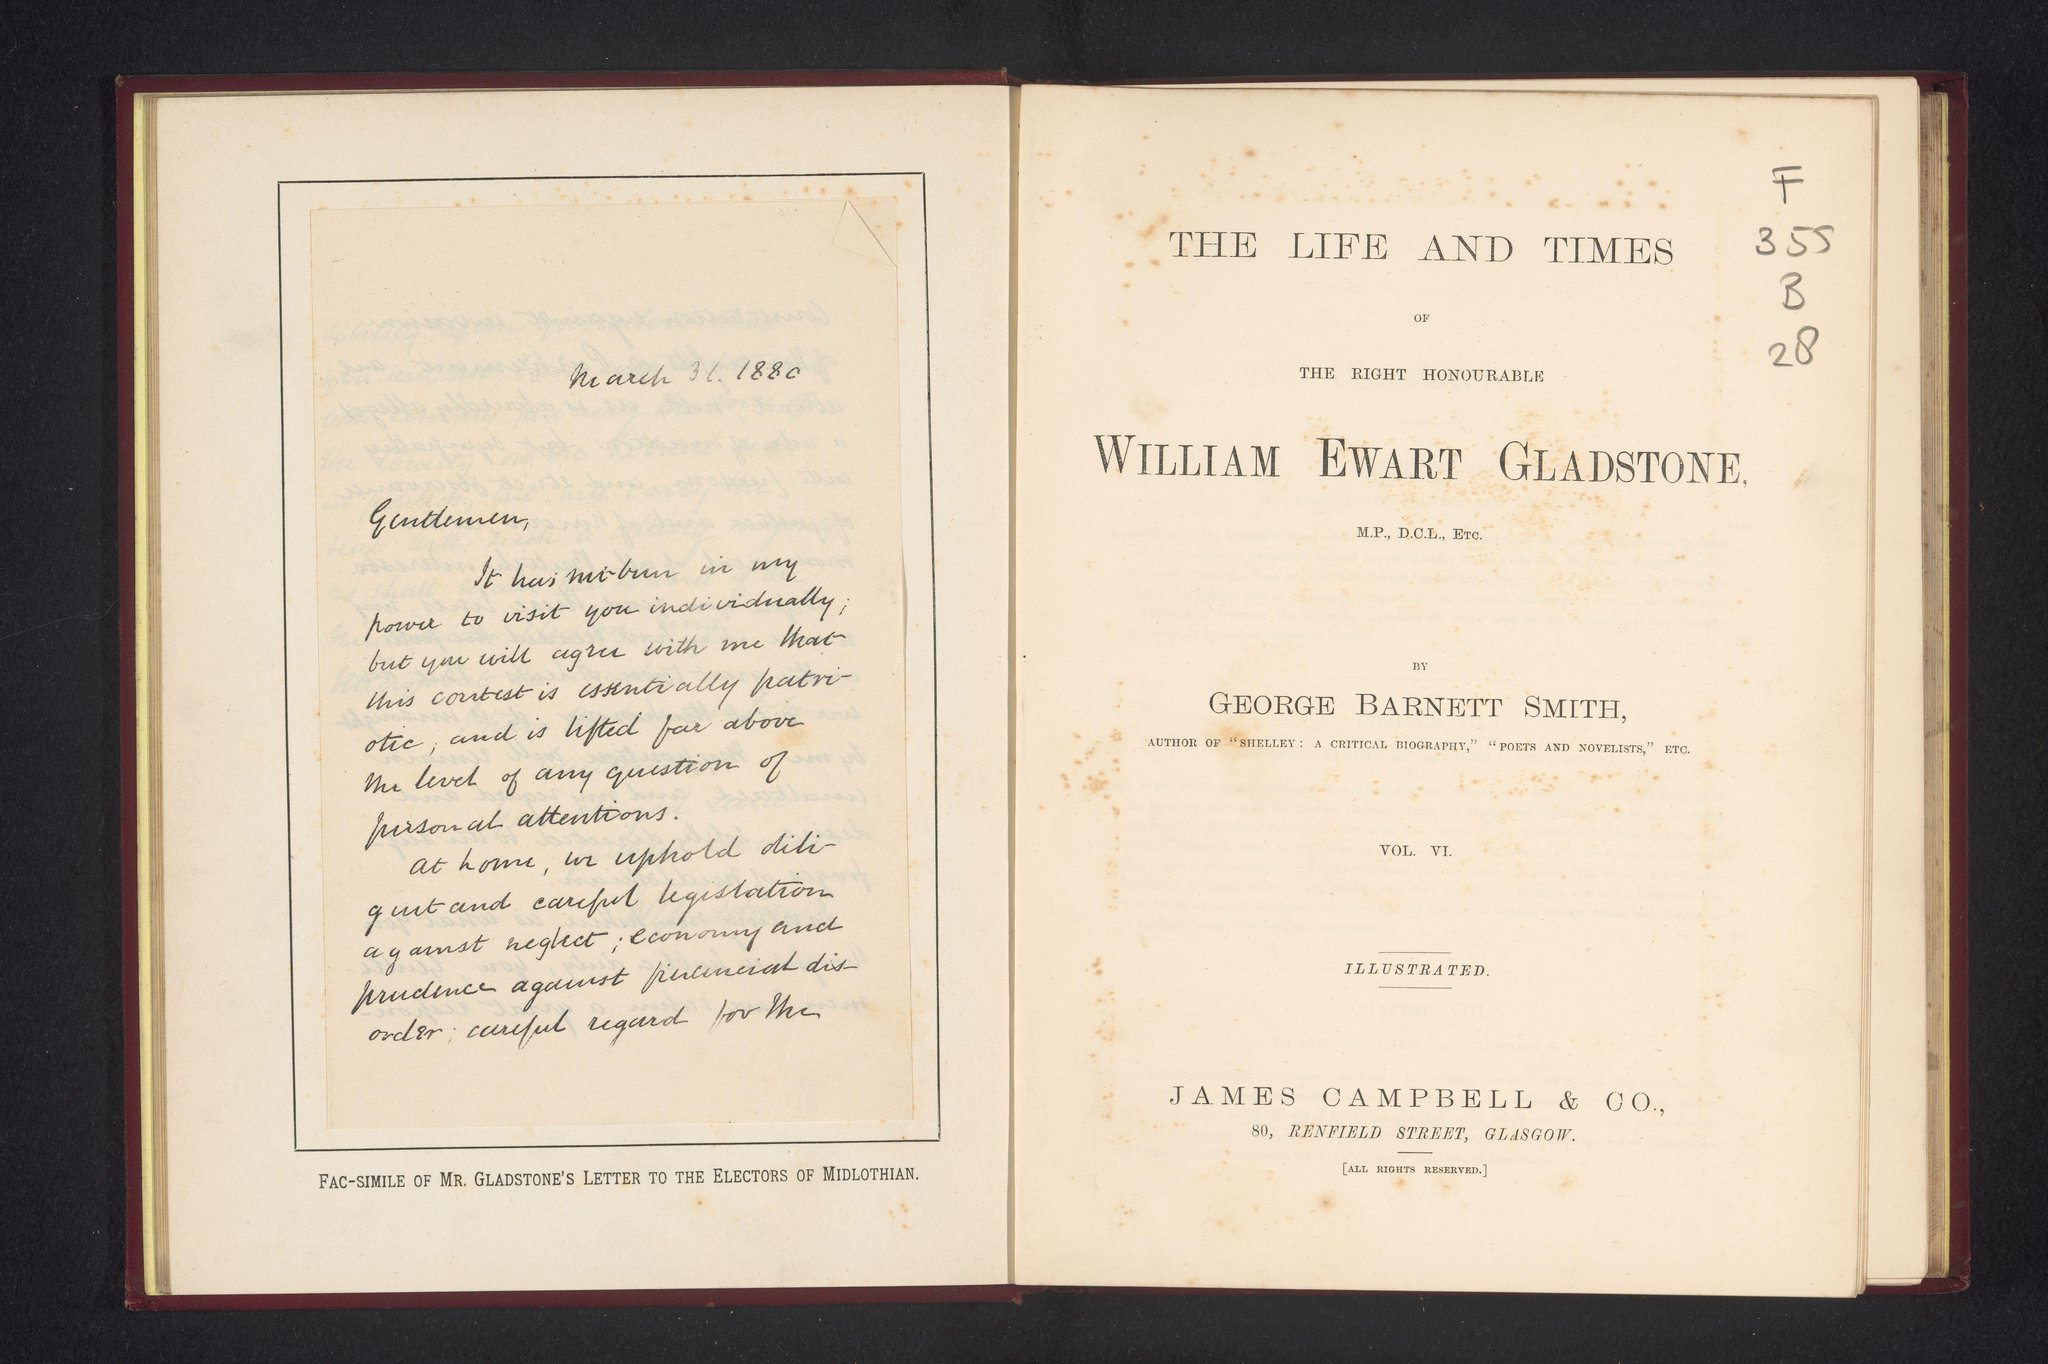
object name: book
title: The life and times of the Right Honourable William Ewart Gladstone volume VI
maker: george barnett smith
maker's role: auteur, journalist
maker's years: 1841-1909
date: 1882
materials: cardboard, linen, paper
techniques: photoaquatint, printing, woodburytype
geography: glasgow